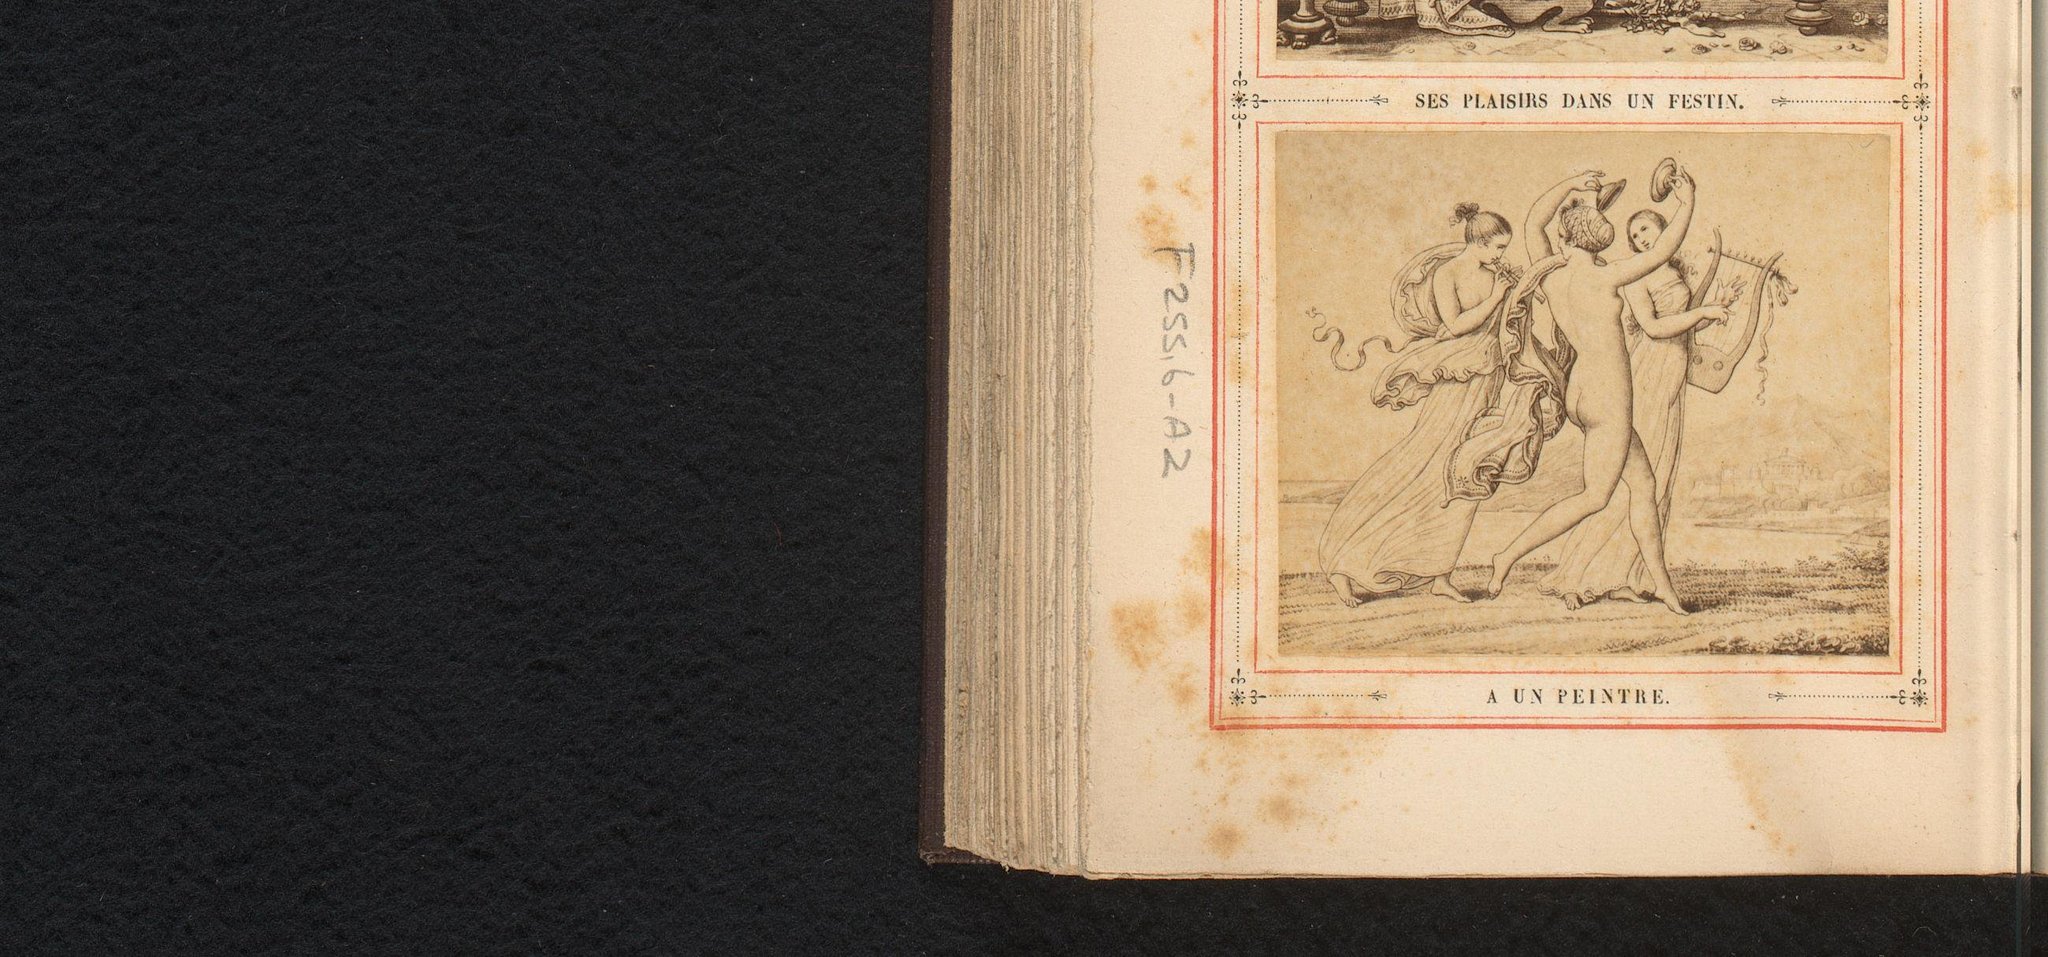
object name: photograph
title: Fotoreproductie van een tekening van Girodet, musicerende goden, illustratie bij Apothéose d'Anacréon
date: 1859-1864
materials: paper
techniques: albumen print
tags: gods ~ classical mythology